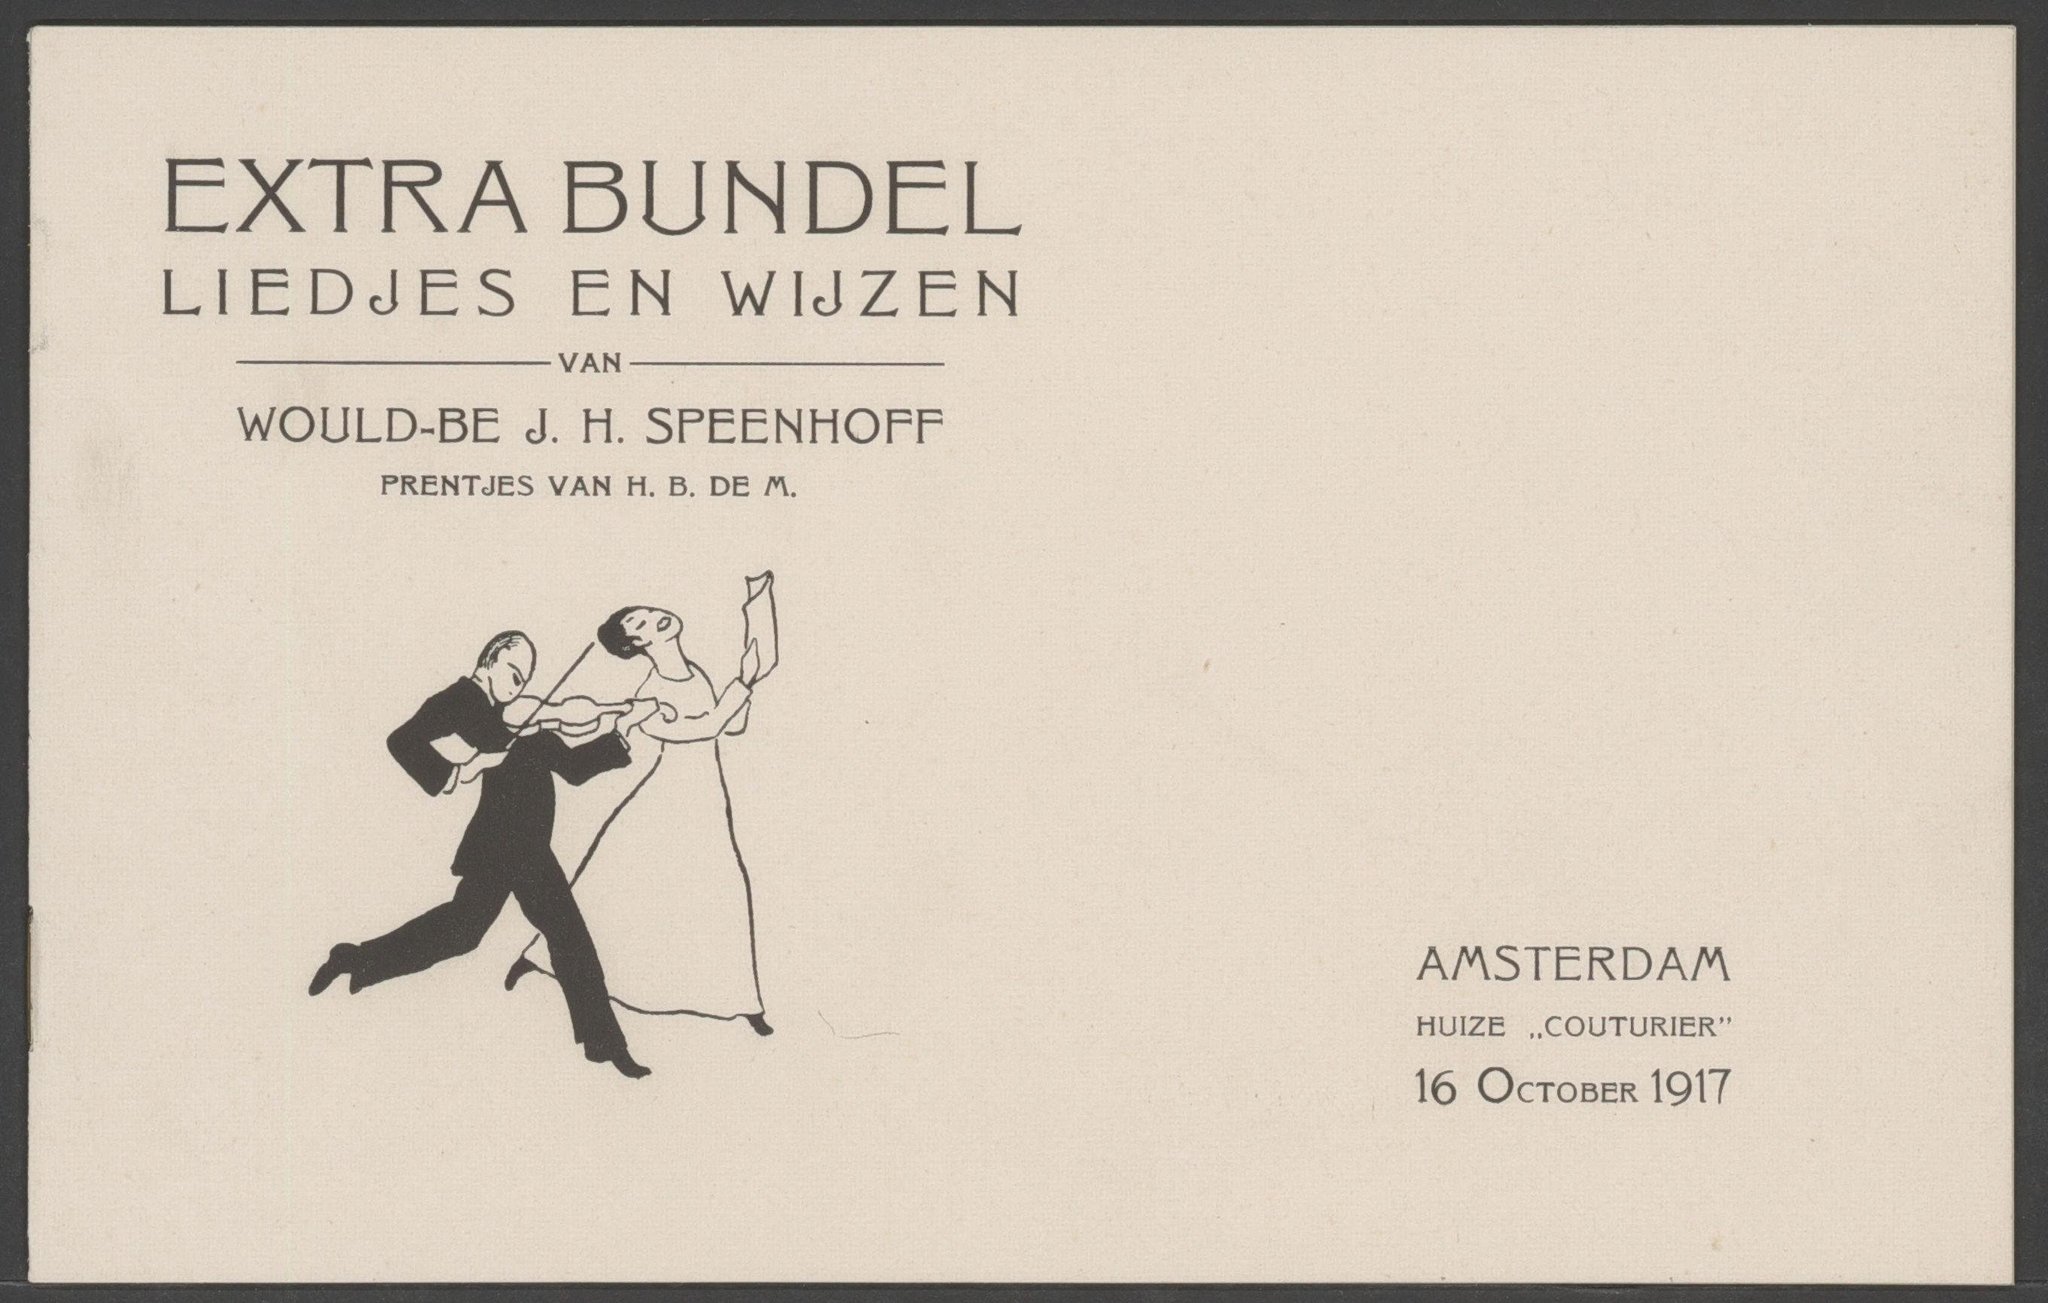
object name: print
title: Boekje met voordrachten gehouden na het huwelijksmaal ter gelegenheid van het huwelijk tussen Louise Lopes de Leâo Laguna en Henri Godfried Victor Hijmans, op 16 oktober 1917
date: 1910-1917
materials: paper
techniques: lithograph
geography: netherlands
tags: wedding feast, wedding meal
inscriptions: collector's mark: Lugt 1641, collector's mark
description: Geïllustreerd boekje met teksten van de voordrachten en liedjes voor het bruidspaar na het huwelijksmaal in Huize 'Couturier'. Bij het huwelijk tussen Louise Lopes de Leâo Laguna en Henri Godfried Victor Hijmans, te Amsterdam op 16 oktober 1917. Onderdeel van een groep van twaalf objecten rondom het huwelijk in de familie Lopes de Leâo Laguna. Onderwerpsrubrieken binnen de Atlas Zeden en Gewoonten: Des Menschen Begin, Midden en Einde. Bruiloft en huwelijk.